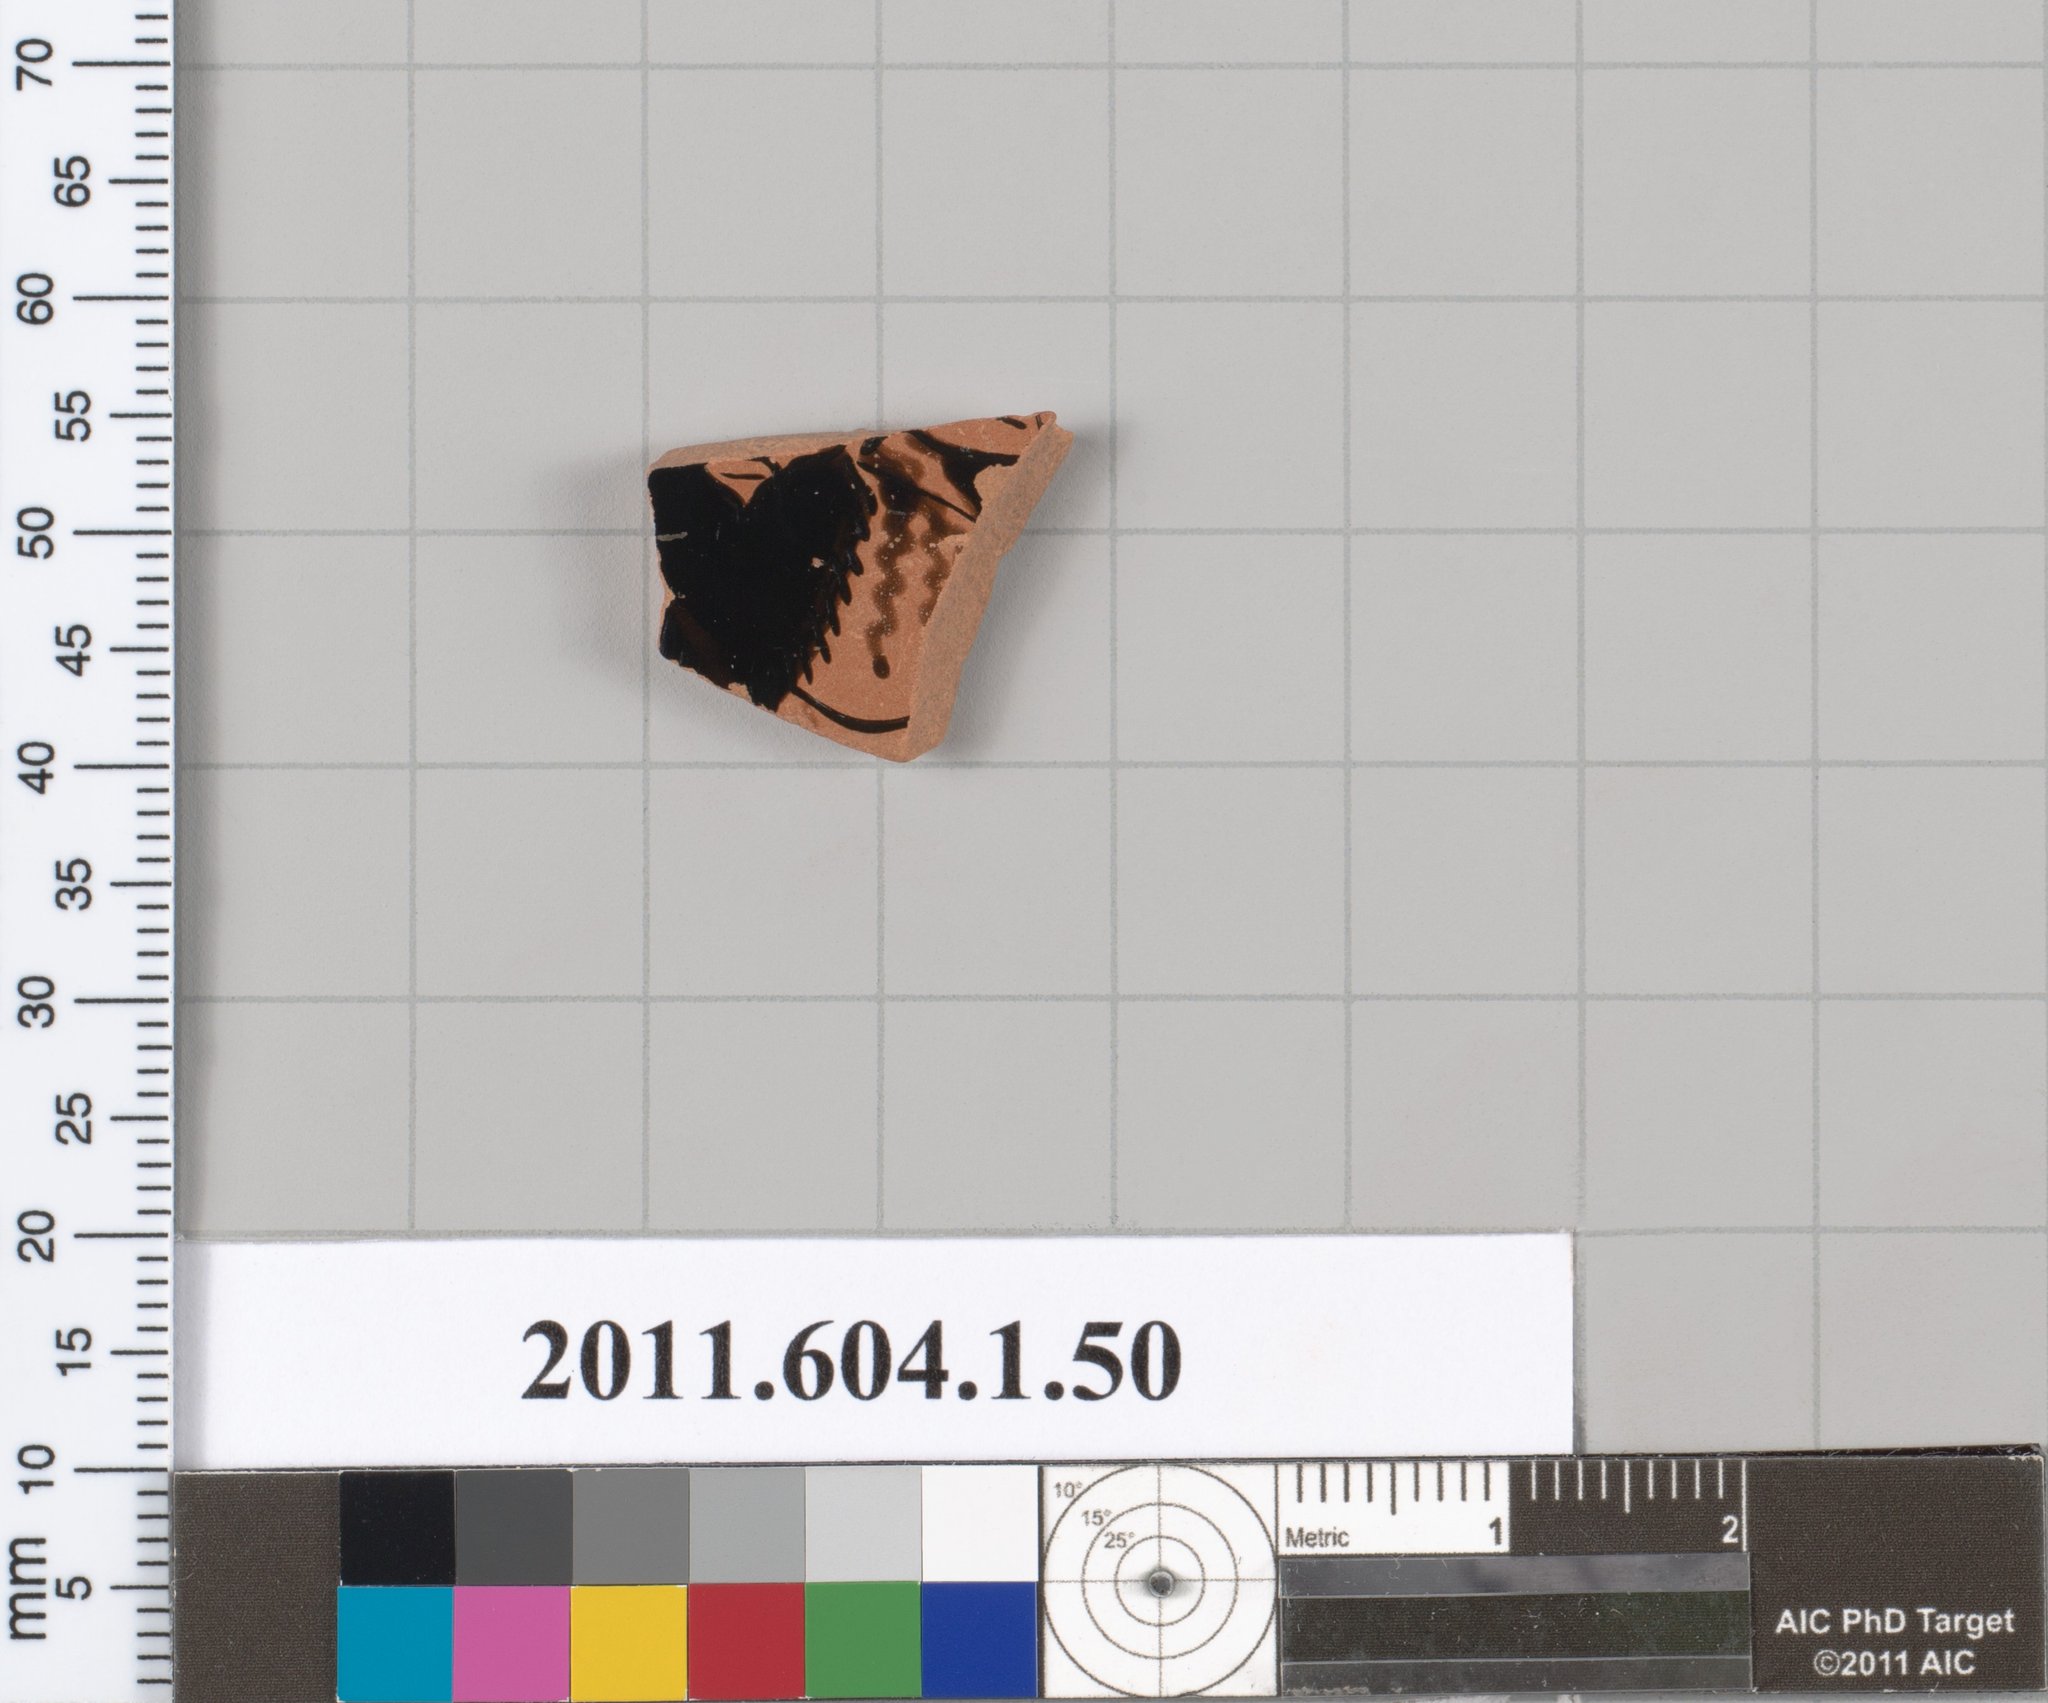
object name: kylix fragment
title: Terracotta fragment of a kylix (drinking cup)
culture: greek, attic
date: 490-480 BCE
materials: terracotta